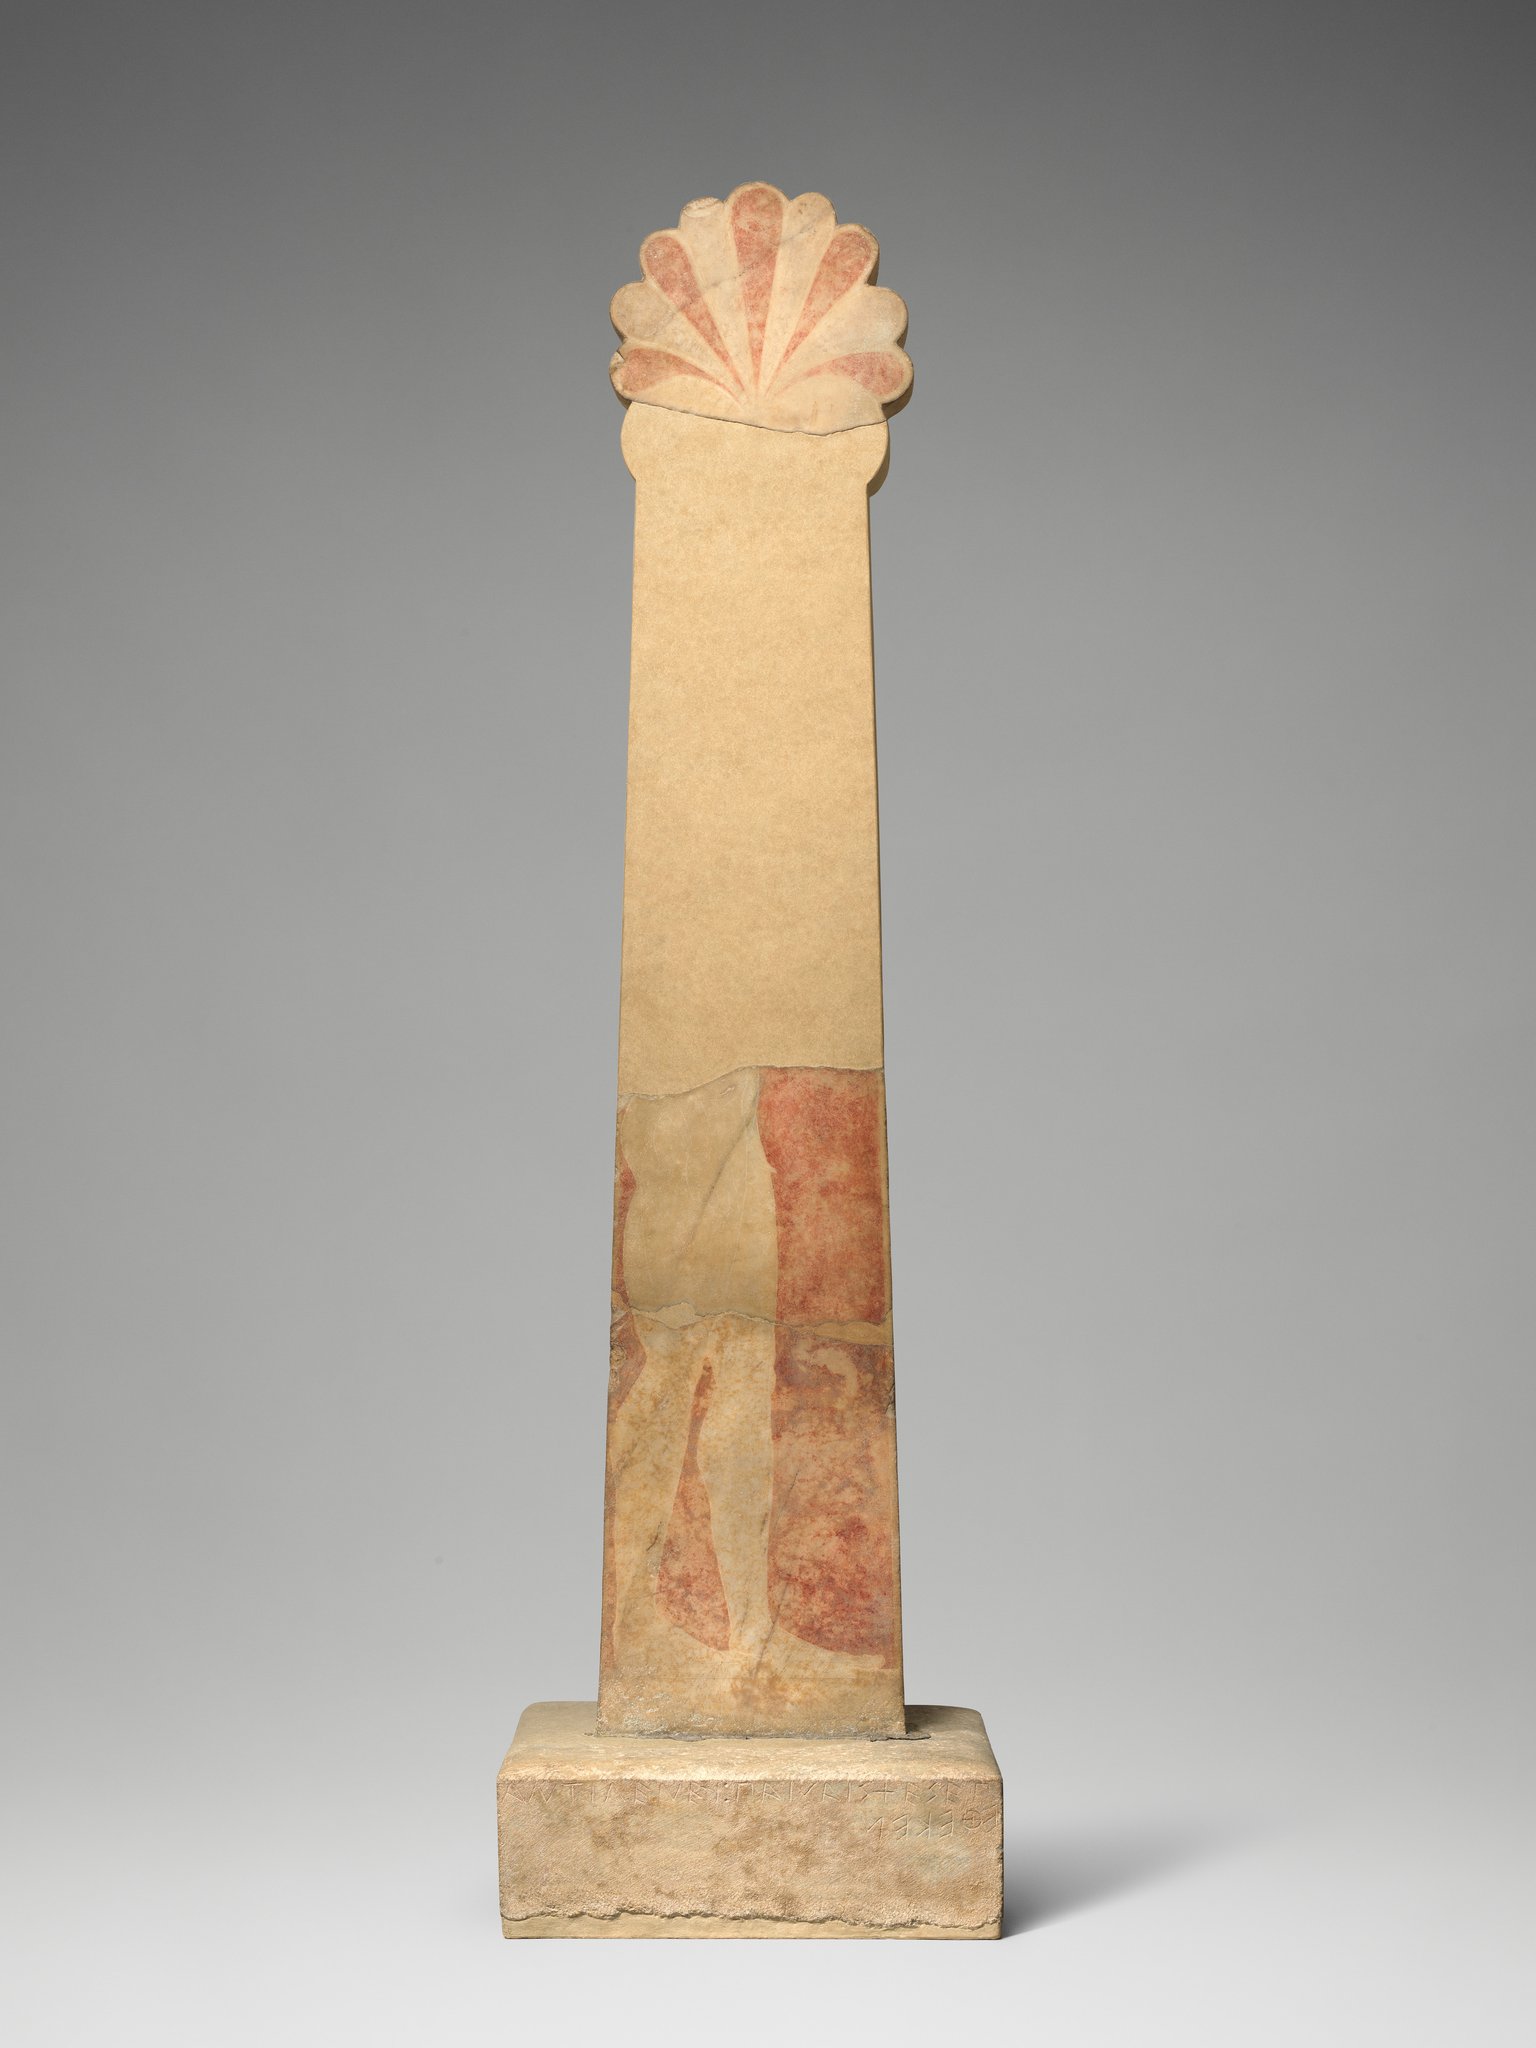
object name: grave stele of antigenes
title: Marble grave stele of Antigenes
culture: greek, attic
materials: marble